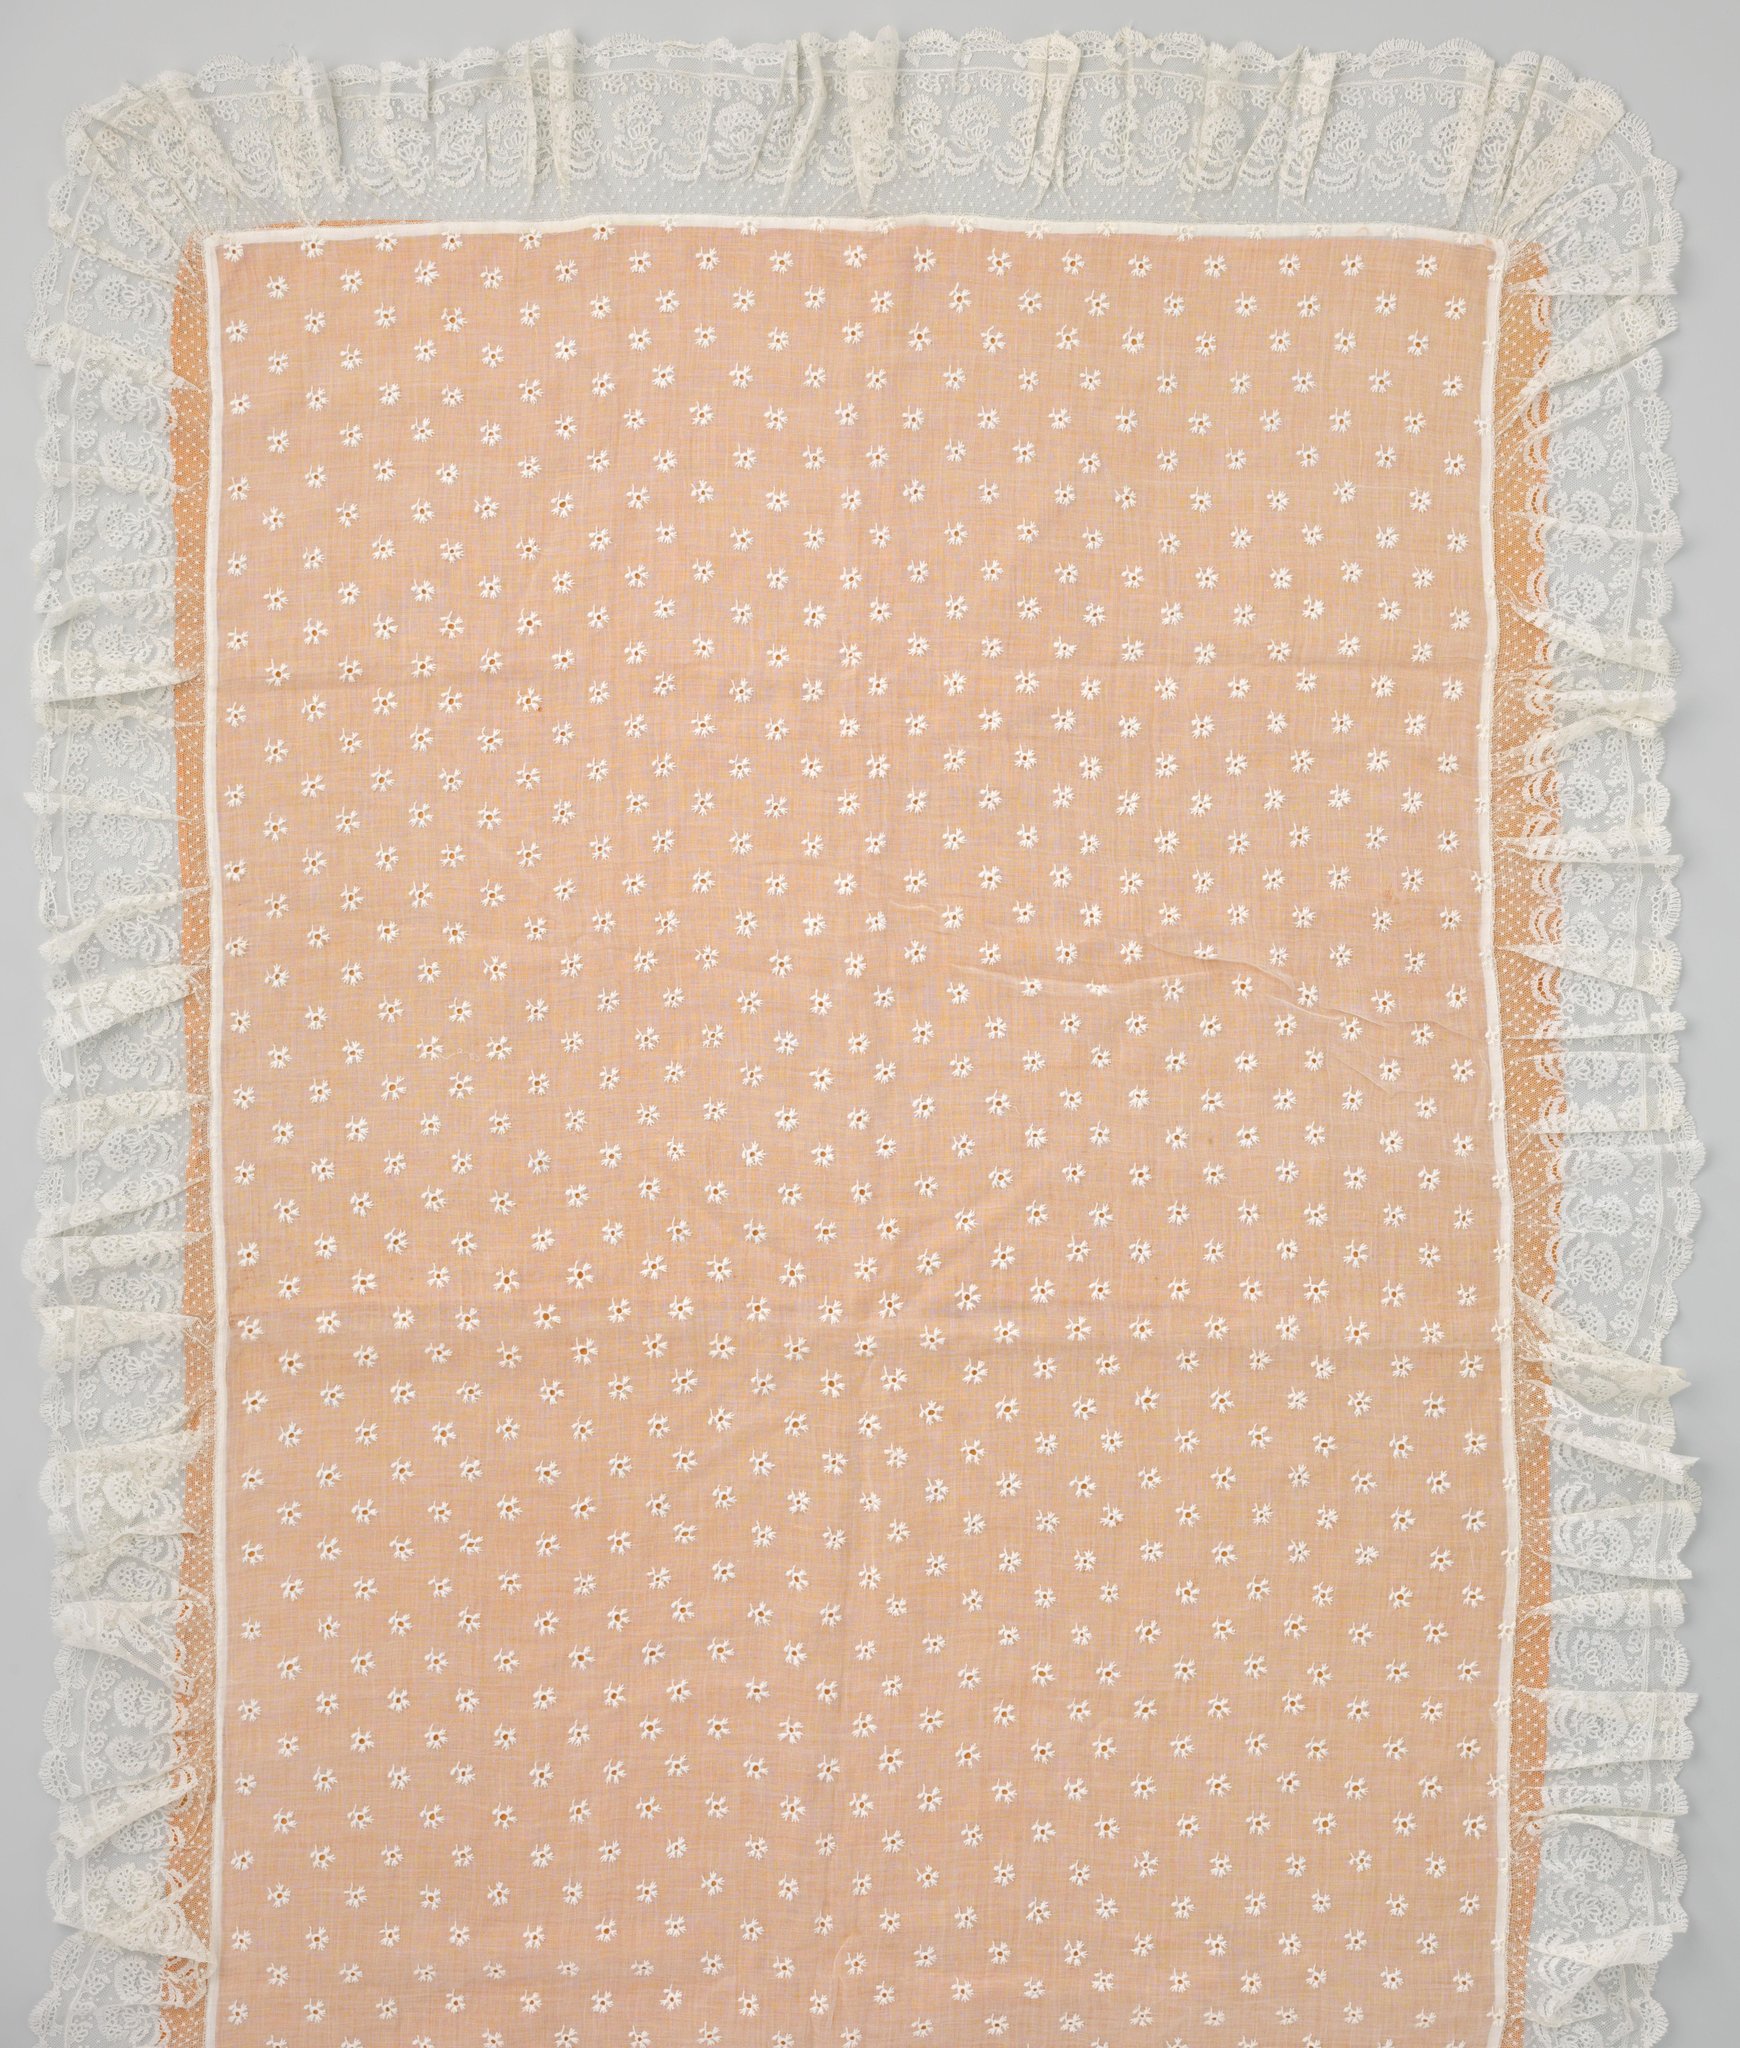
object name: doopkleed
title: Doopkleed van batist met strooibloemen, een gerimpeld aangezette strook geschulpte kant en oranje voering van zijde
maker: Anonymous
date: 1825-1845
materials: textile, silk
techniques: embroidered, lace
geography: netherlands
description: Doopkleed van batist met strooibloempjes, kant en oranje voering. Borduurpatroon: strooimotief van een fijn korenbloempje met open hartje. Kant: type Lille, met patroon van grote hangende bloemen op een moesjesfond en door gevederd blad met "punaises" gedekt. Voering: oranje ponjé-zijde. Opmerking: in 1968 gewassen.